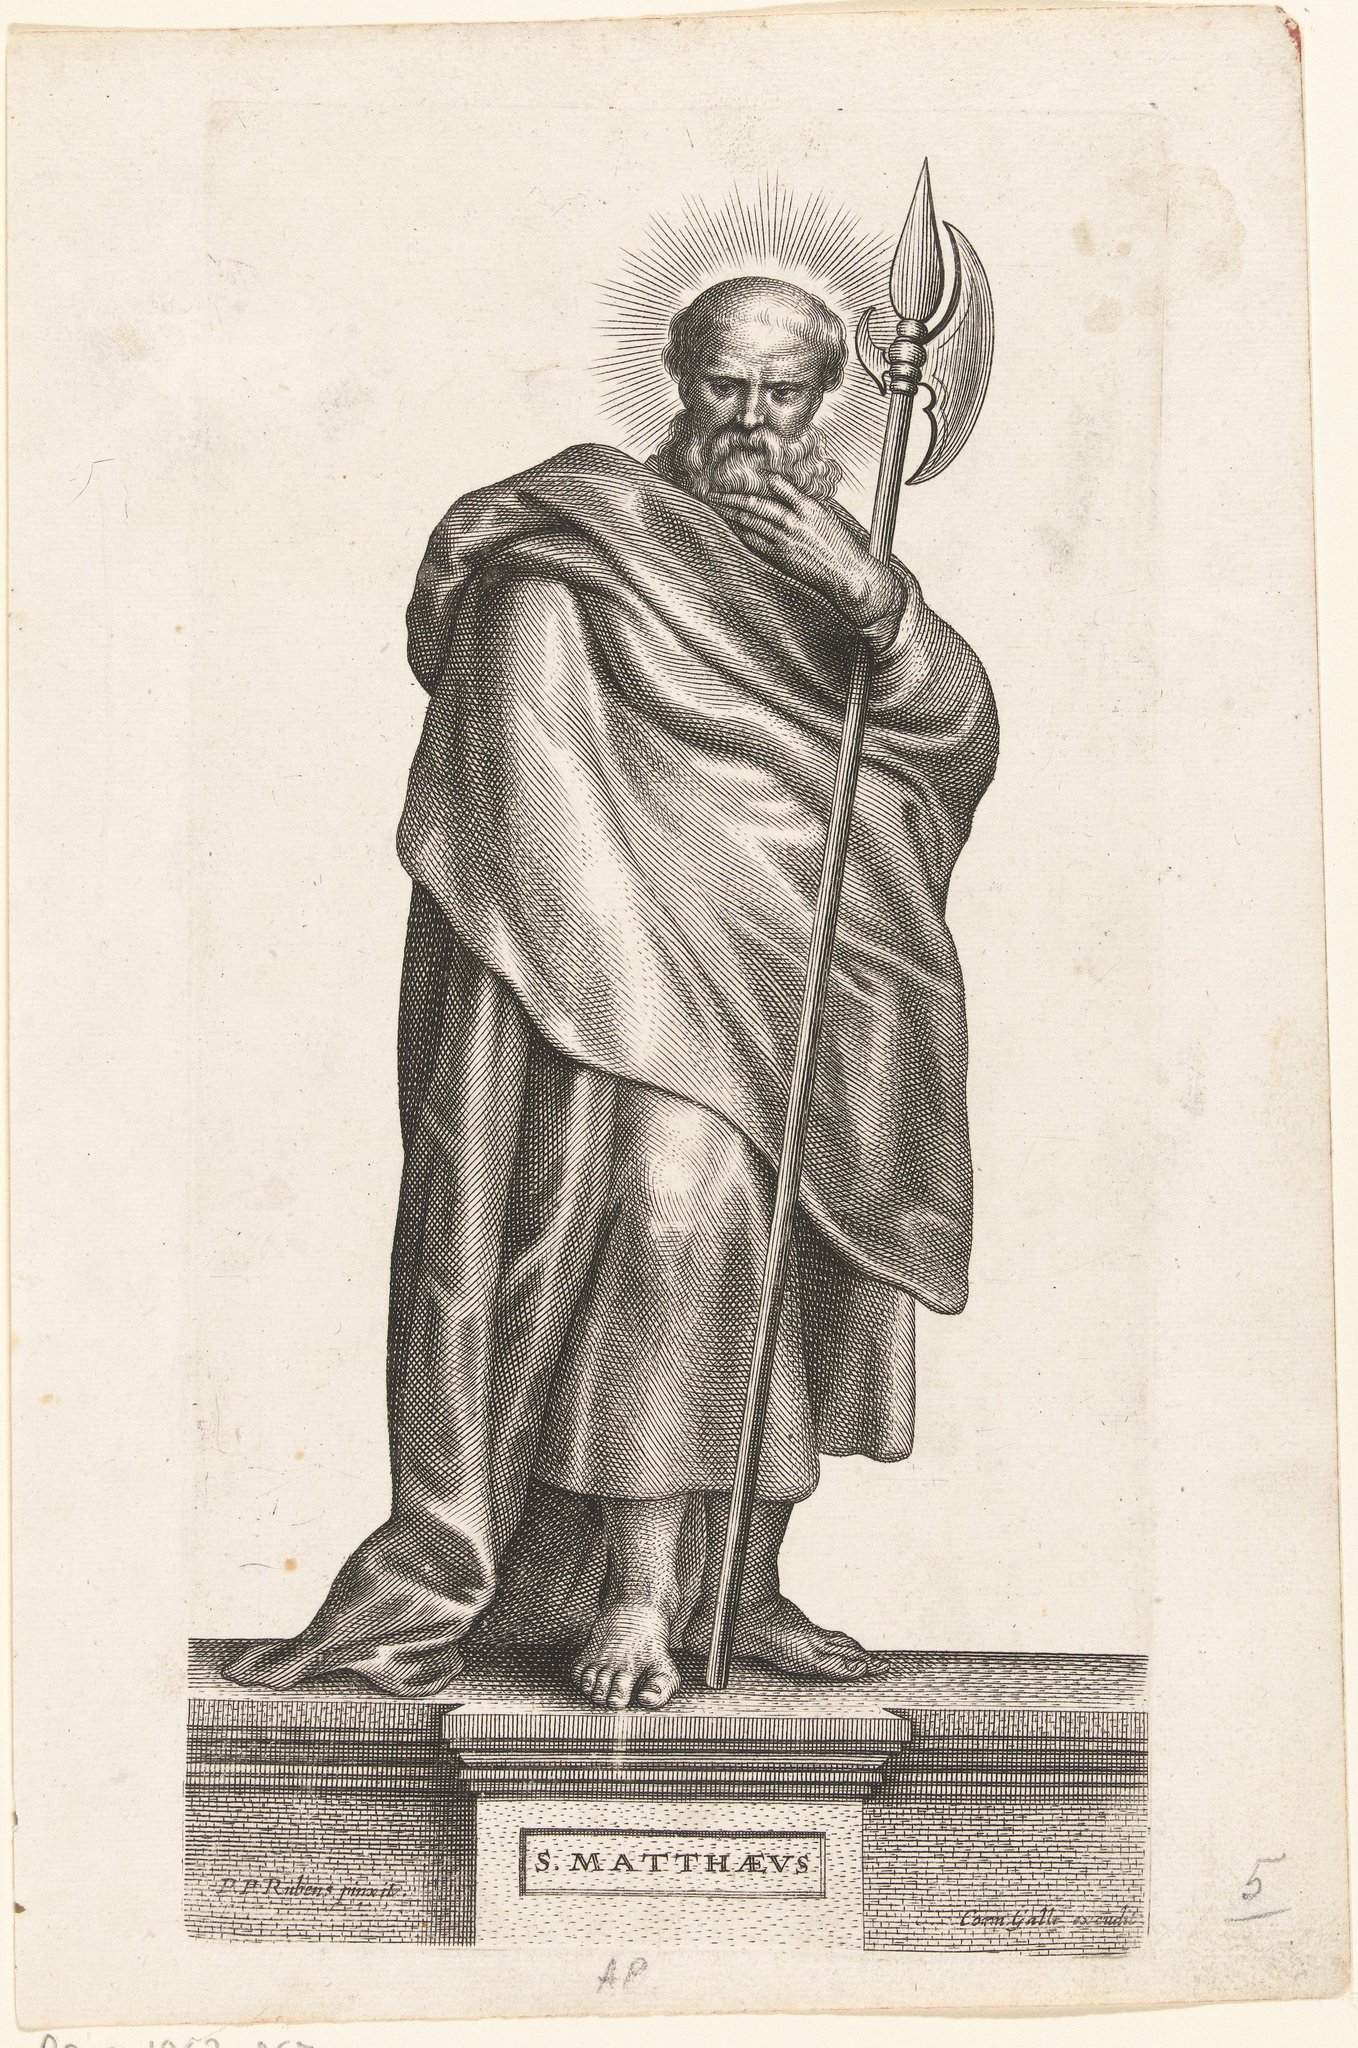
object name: print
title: SS Apostolorum Iconen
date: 1639-1670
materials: paper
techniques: engraving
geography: antwerp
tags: the apostle and evangelist matthew (mattheus); possible attributes: angel, axe, book, halberd, pen and inkhorn, purse, scroll, square, sword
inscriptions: collector's mark: Lugt 2760, collector's mark: Lugt 2228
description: De prent toont de Heilige Matteüs. In zijn linkerhand zijn martelwerktuig, de hellebaard. De serie bestaat uit prenten gebaseerd op schilderijen van Peter Paul Rubens.